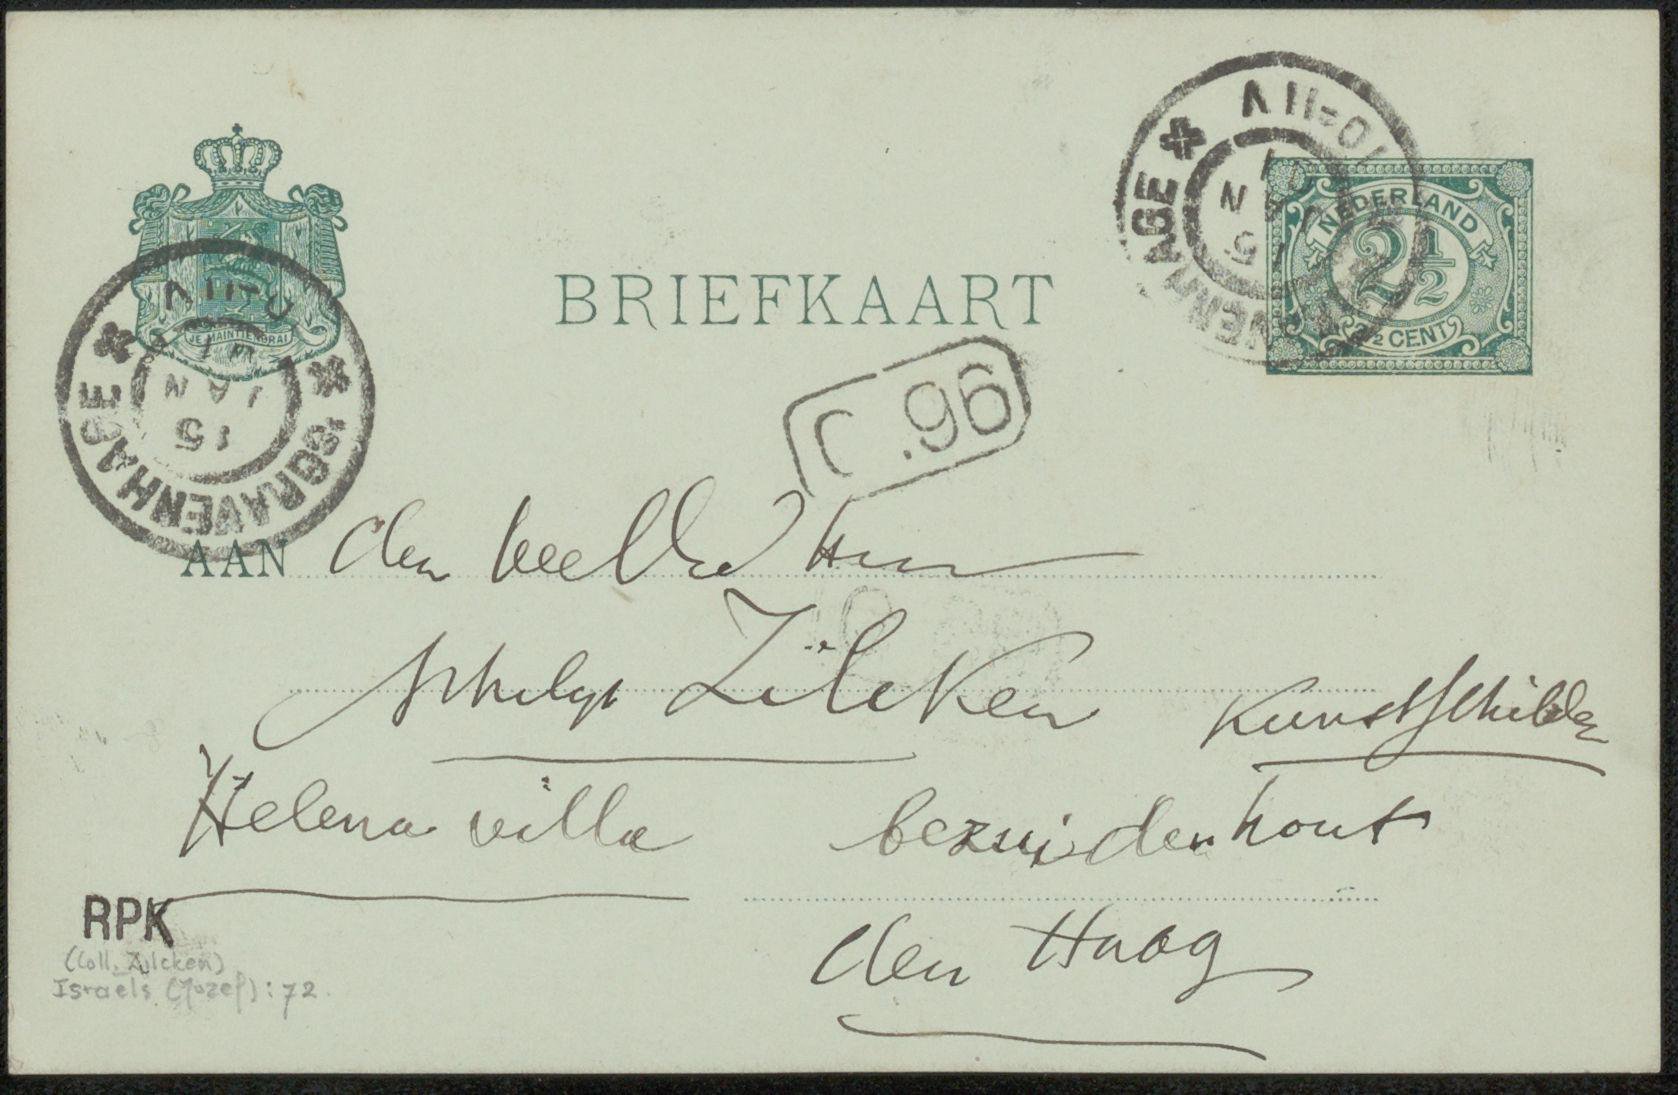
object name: postcard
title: Briefkaart aan Philip Zilcken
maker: jozef israëls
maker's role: draughtsman, painter, print maker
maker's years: 1824-1911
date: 1901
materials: cardboard, ink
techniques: pen, writing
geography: the hague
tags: publisher, painter, draughtsman, philip zilcken, the graphic arts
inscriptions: collector's mark: ‘RPK’